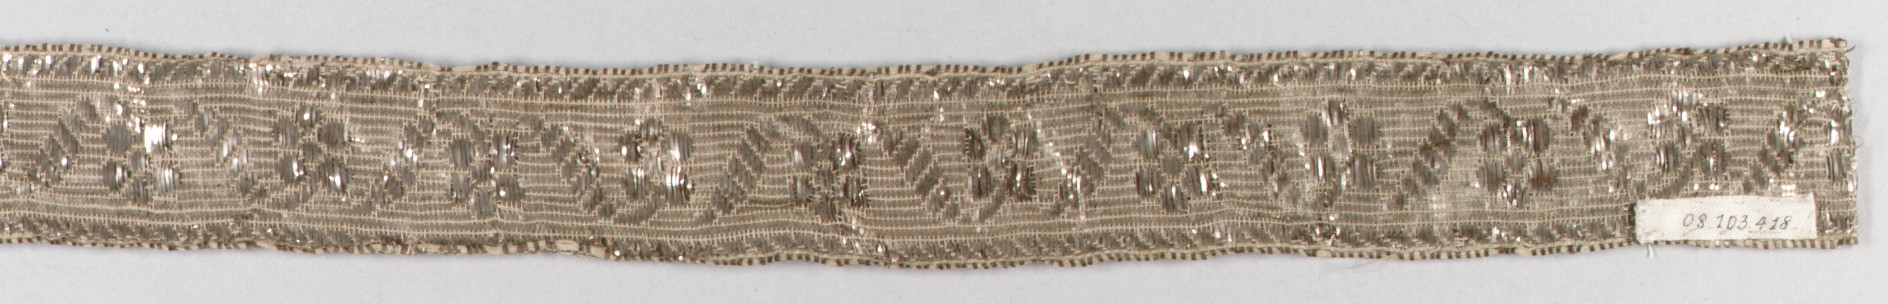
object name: galloon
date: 1701-1800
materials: metal thread